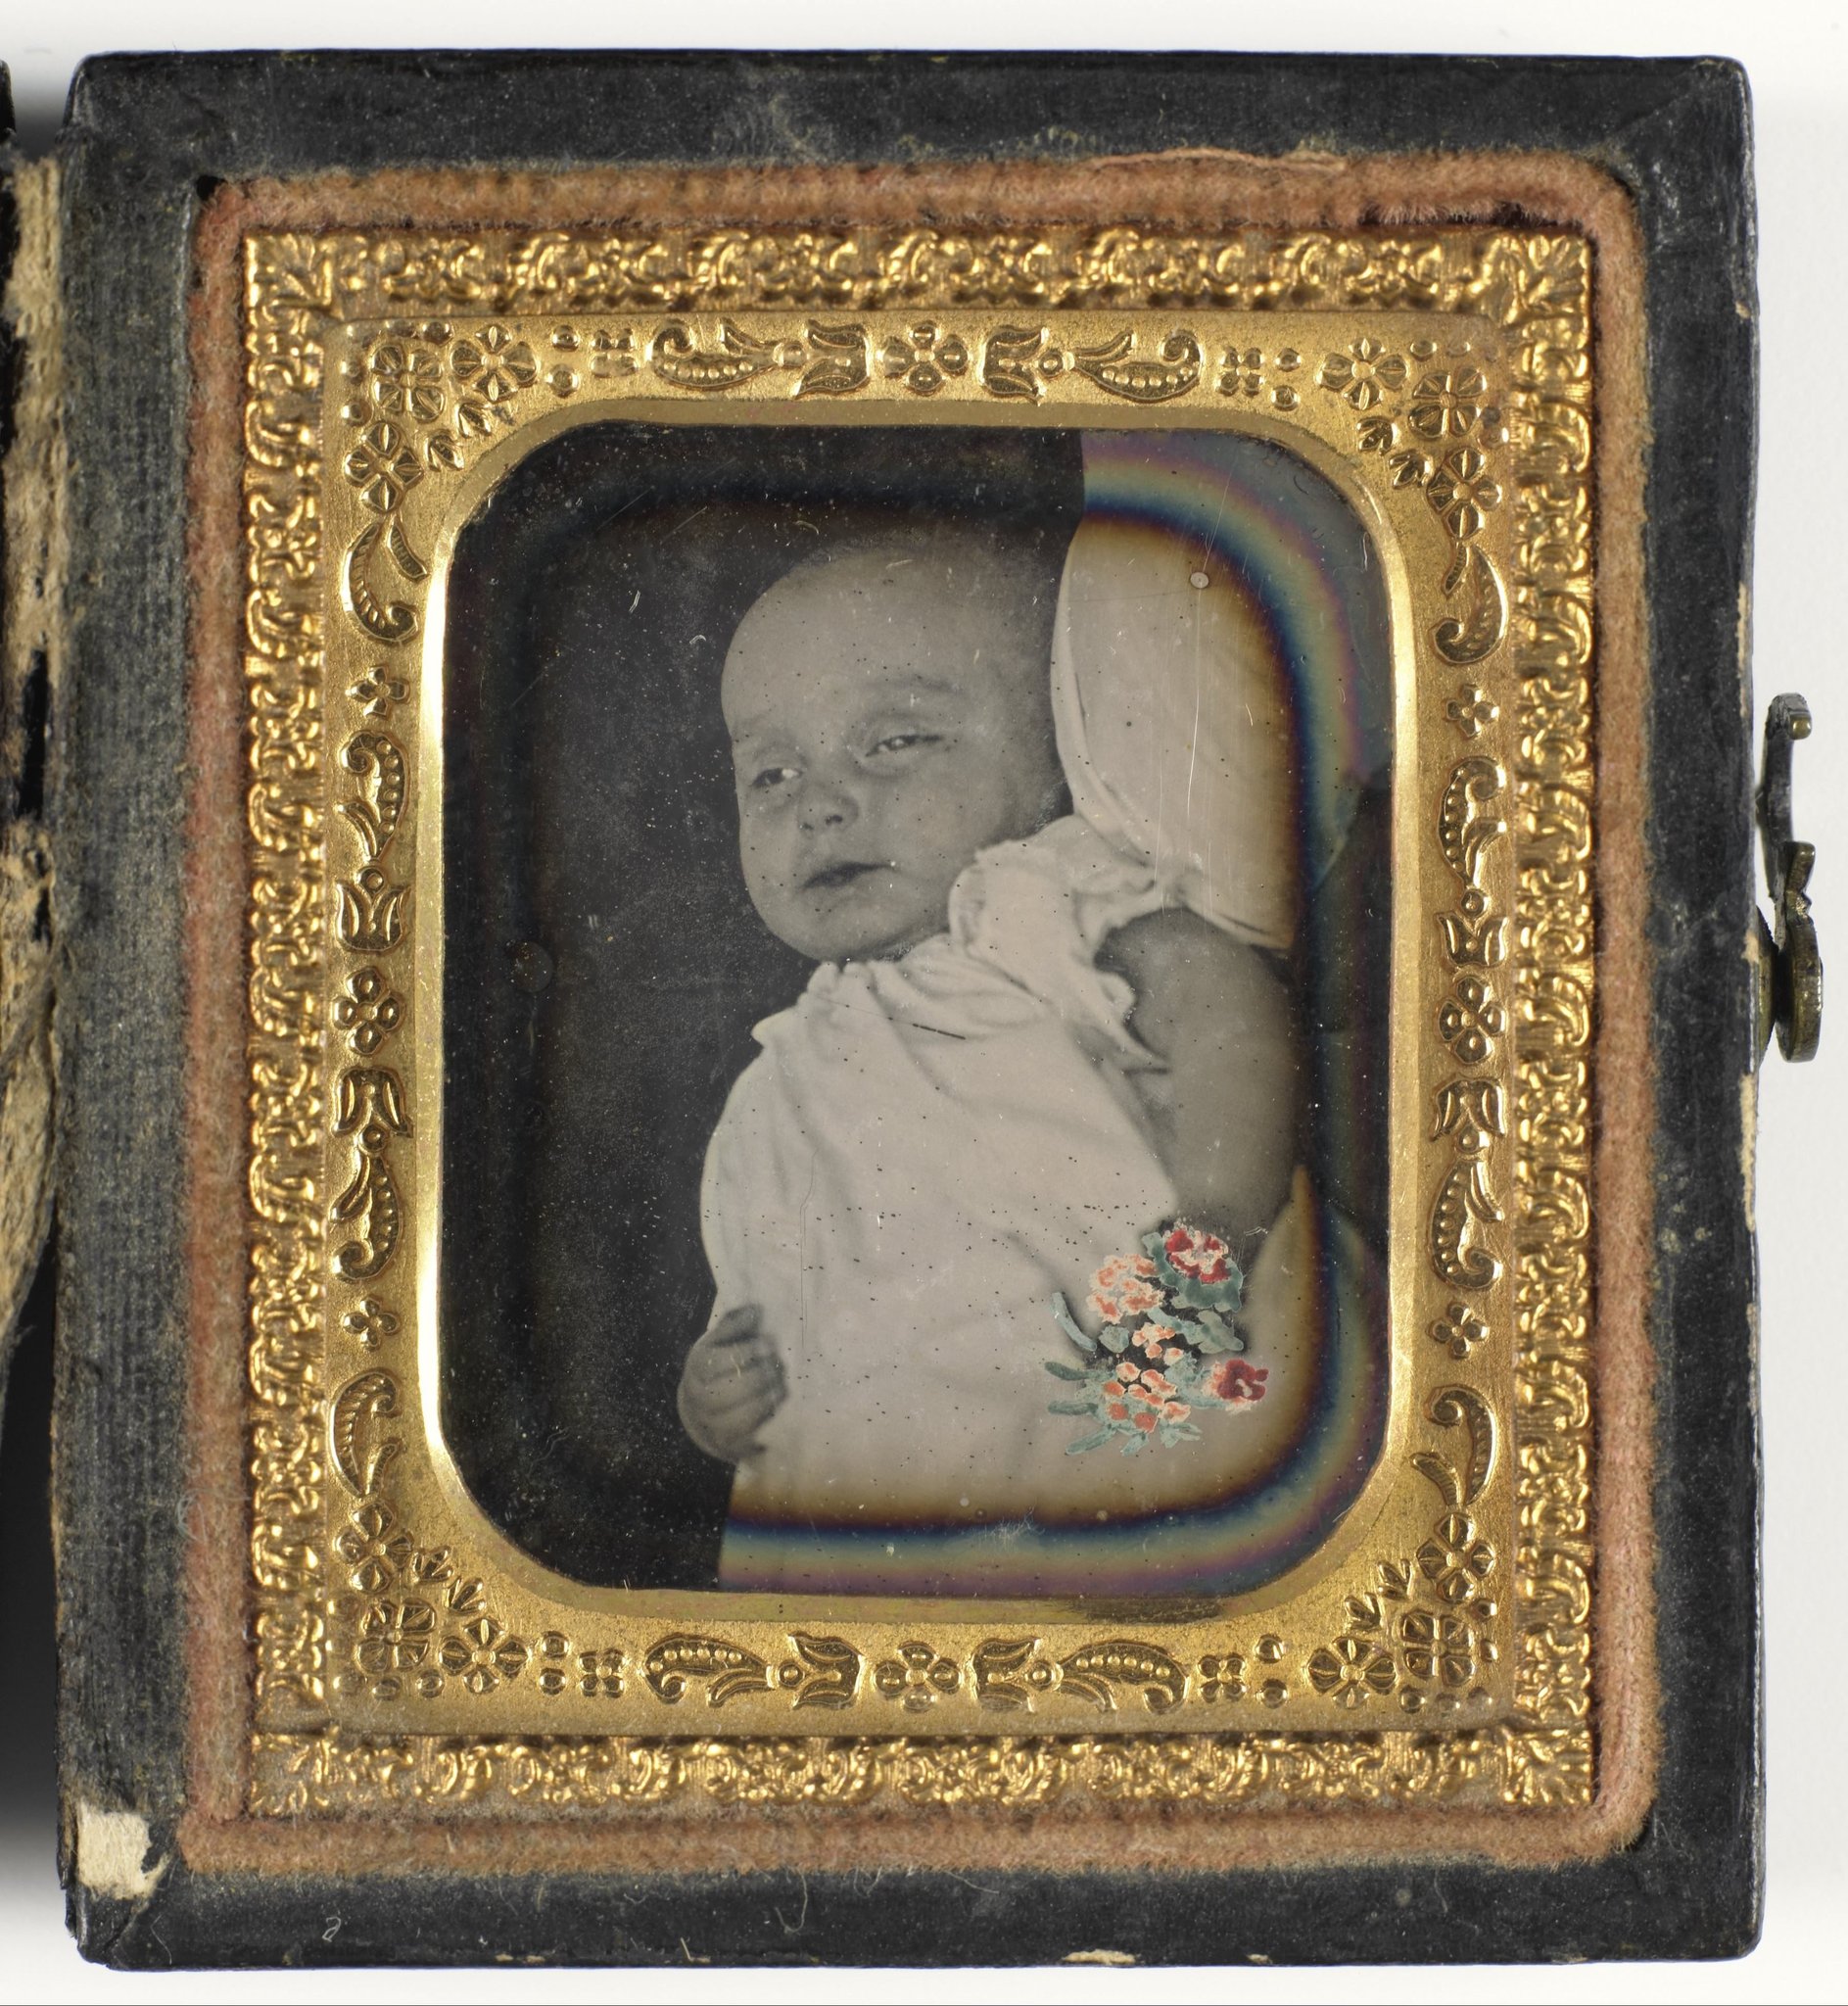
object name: photograph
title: Post-mortemportret van een baby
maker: Anonymous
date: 1856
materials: copper, glass, leather, velvet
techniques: daguerreotype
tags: historical persons, the corpse, infant, baby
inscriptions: annotation: ‘1856’